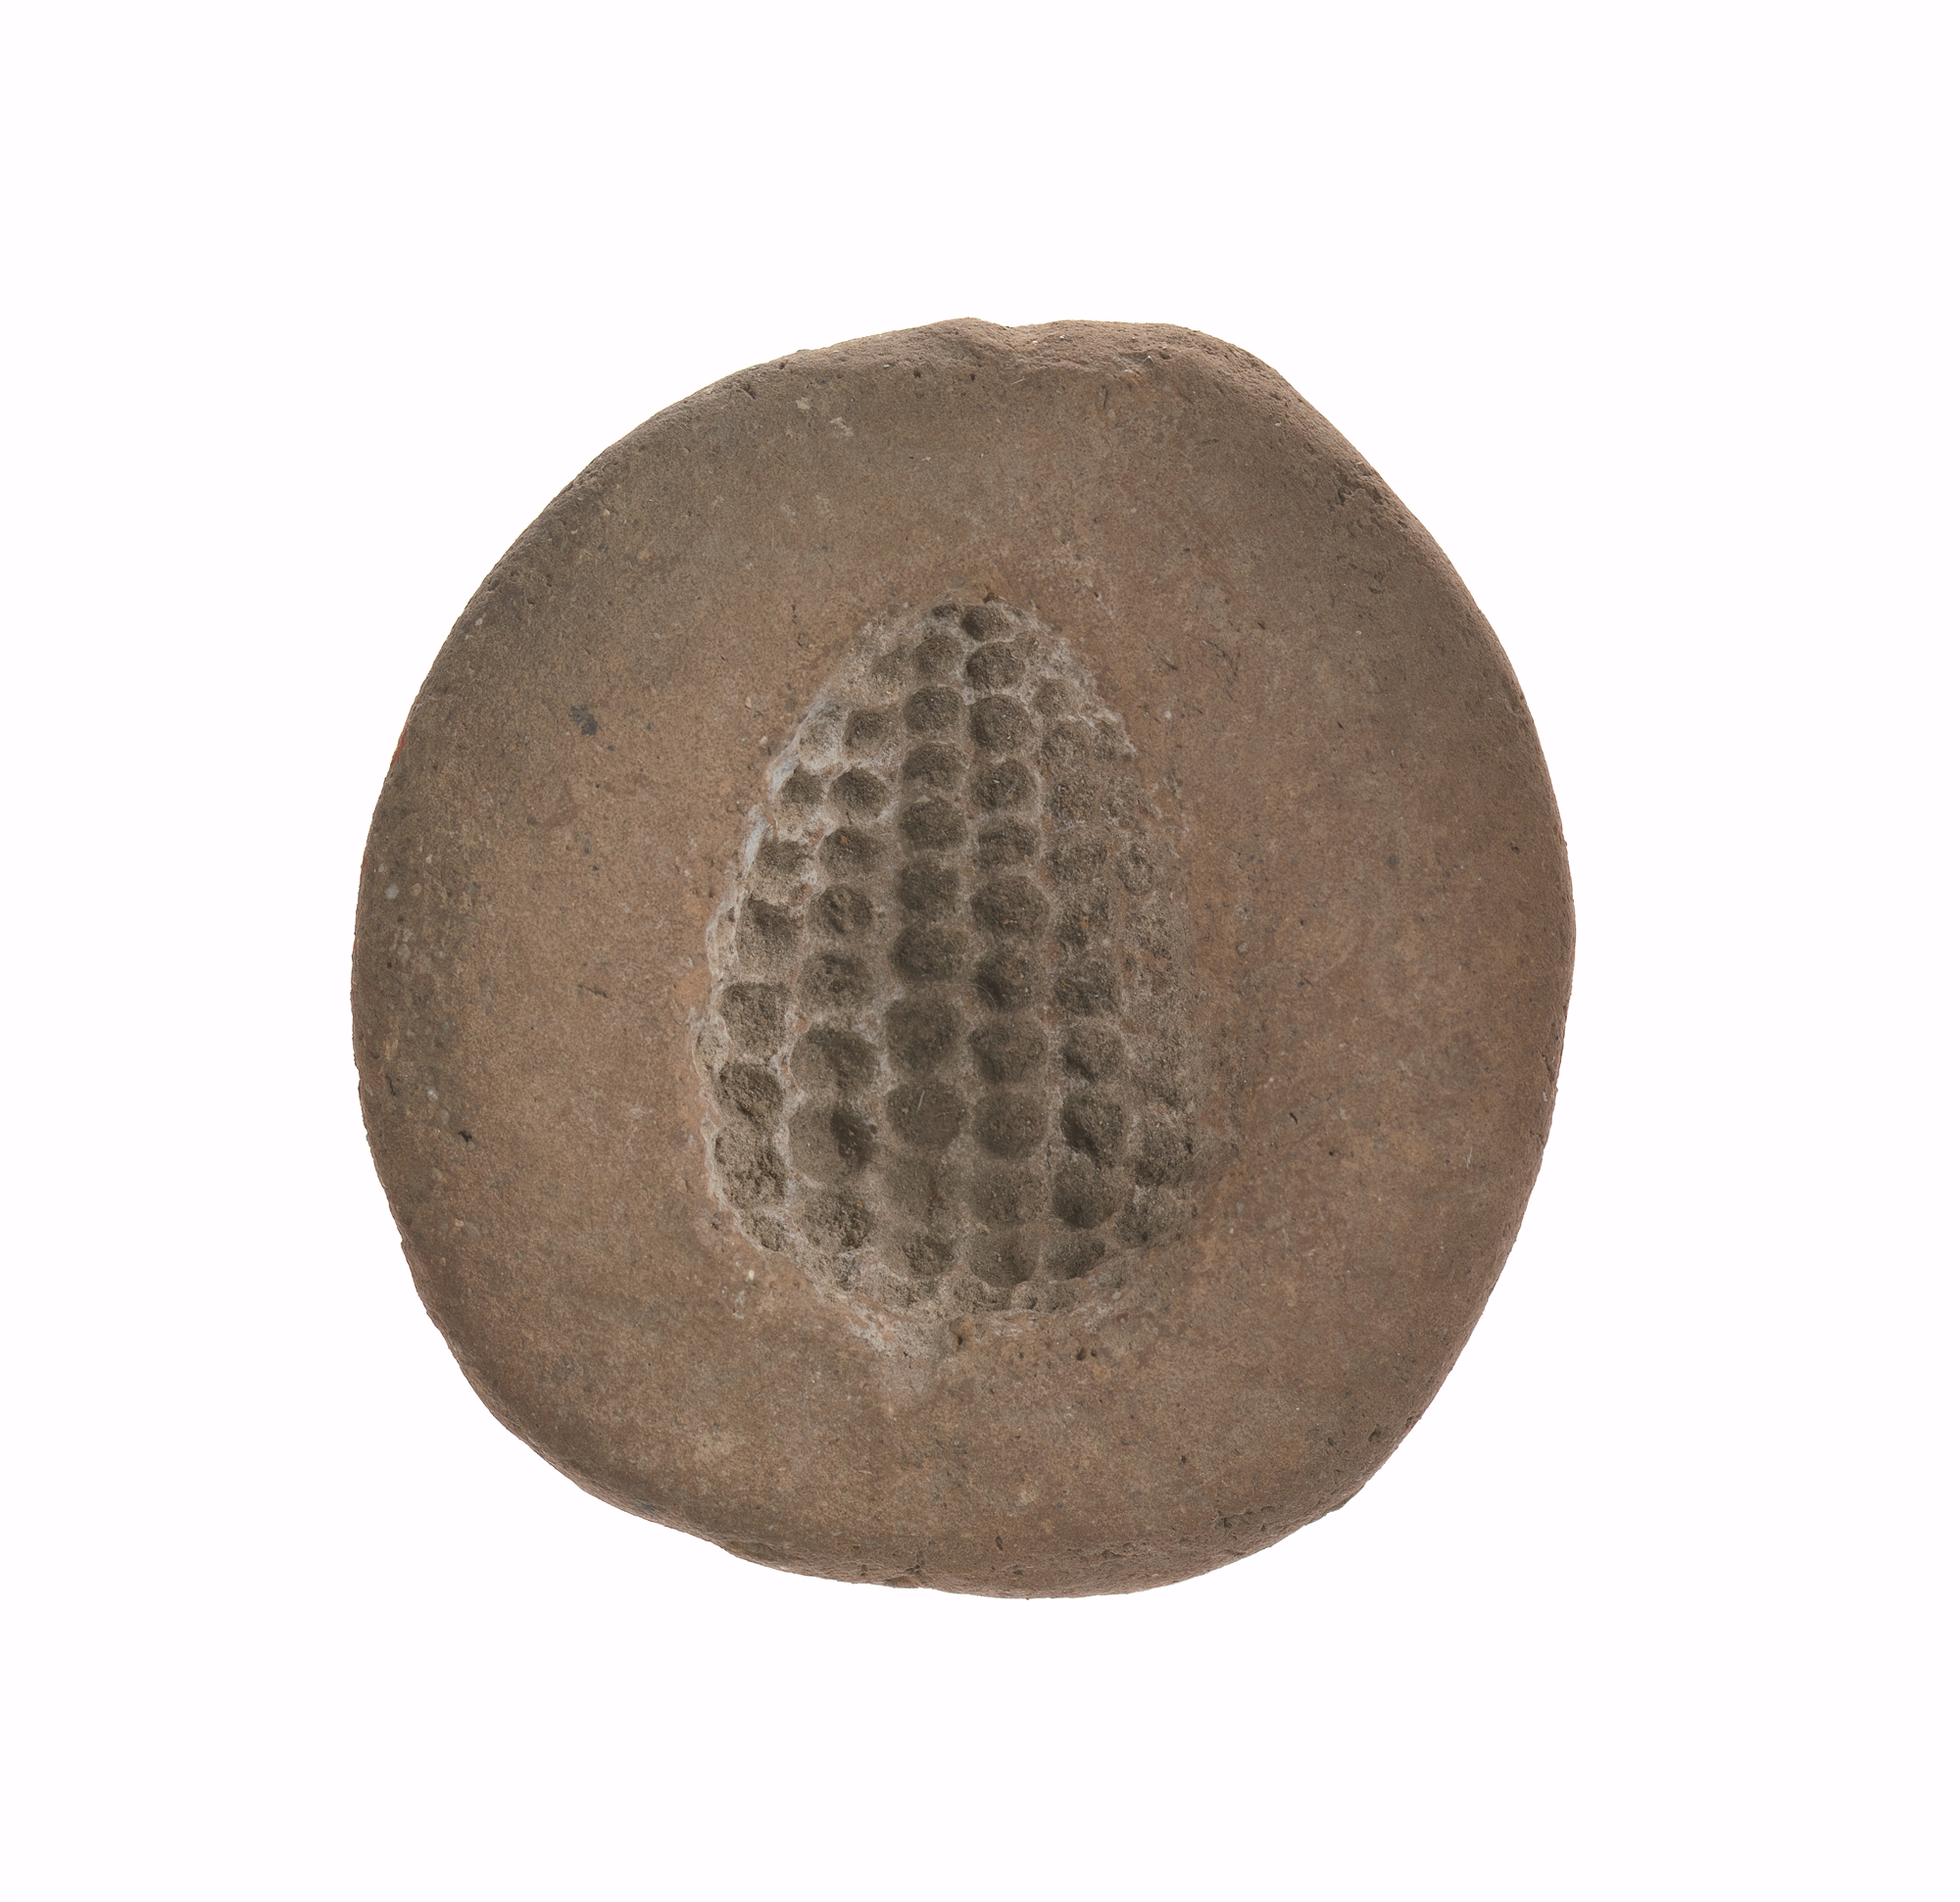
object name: mold, grape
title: Mold for half of a Grape Cluster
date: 1353-1336 BCE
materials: pottery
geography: egypt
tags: grapes